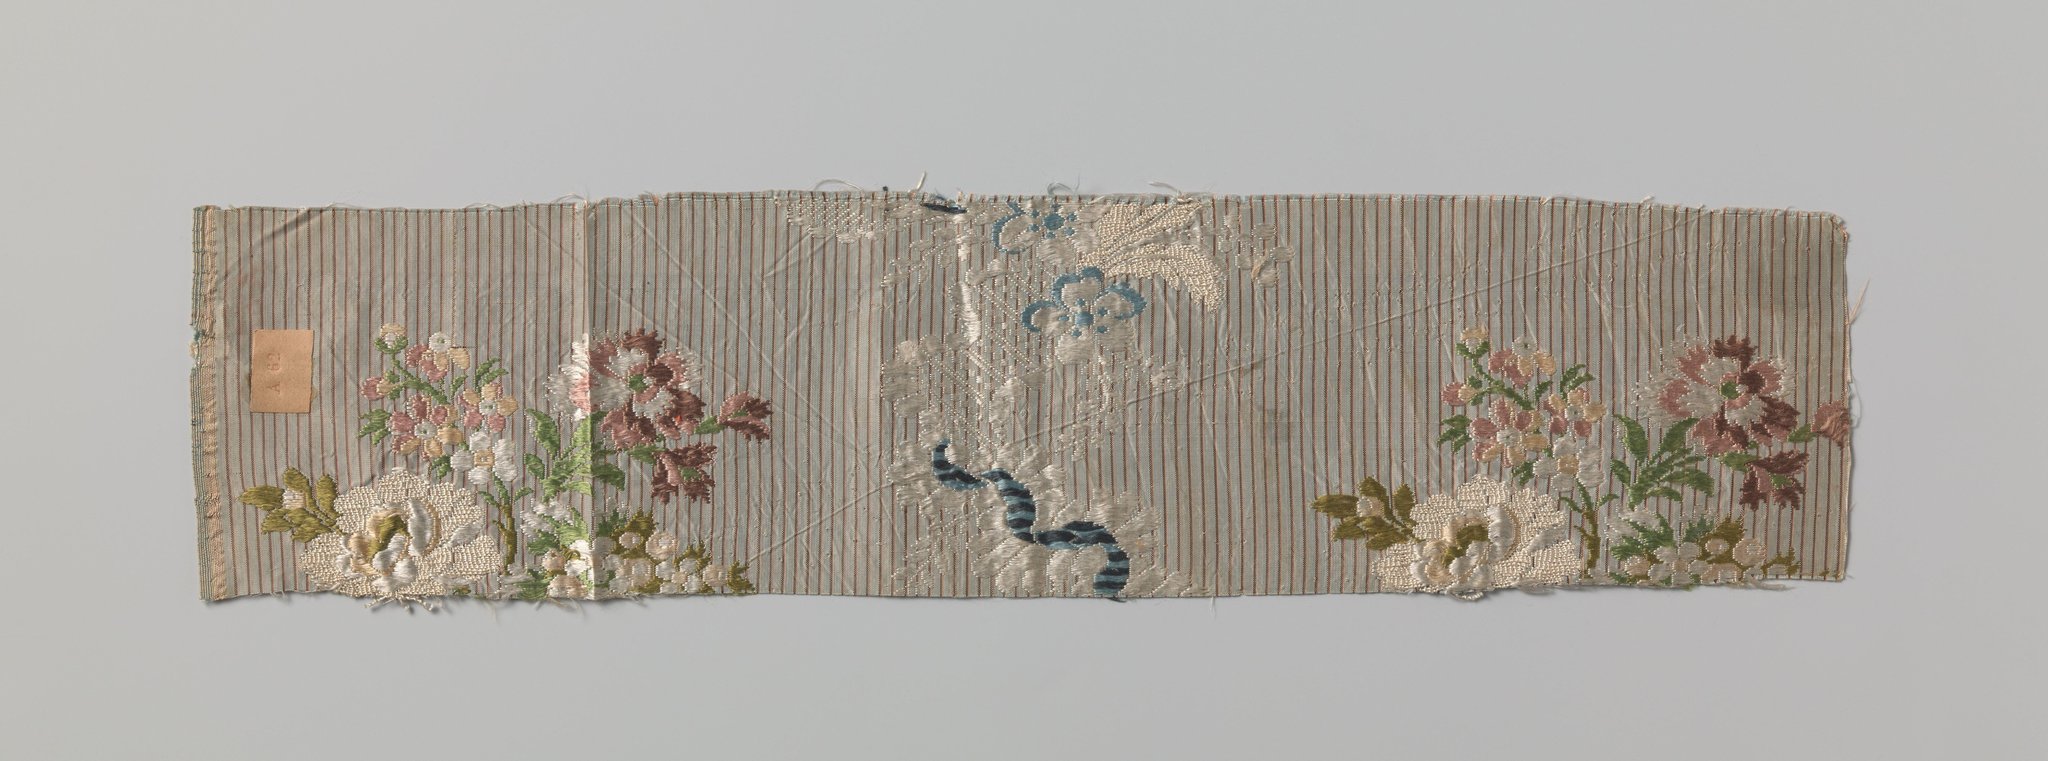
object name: silk textile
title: Fragment gestreepte zijdeweefsel met bloemen en kantslinger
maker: Anonymous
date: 1760-1775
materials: silk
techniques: brocade, weave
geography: france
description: Fragment veelkeurig zijdeweefsel. Een grijze grond heeft dunne rode strepen waarop een witte kantslinger met een blauw gestreept lint en blauw-witte bloemen, waartussen veelkleurige bloemboeketten.